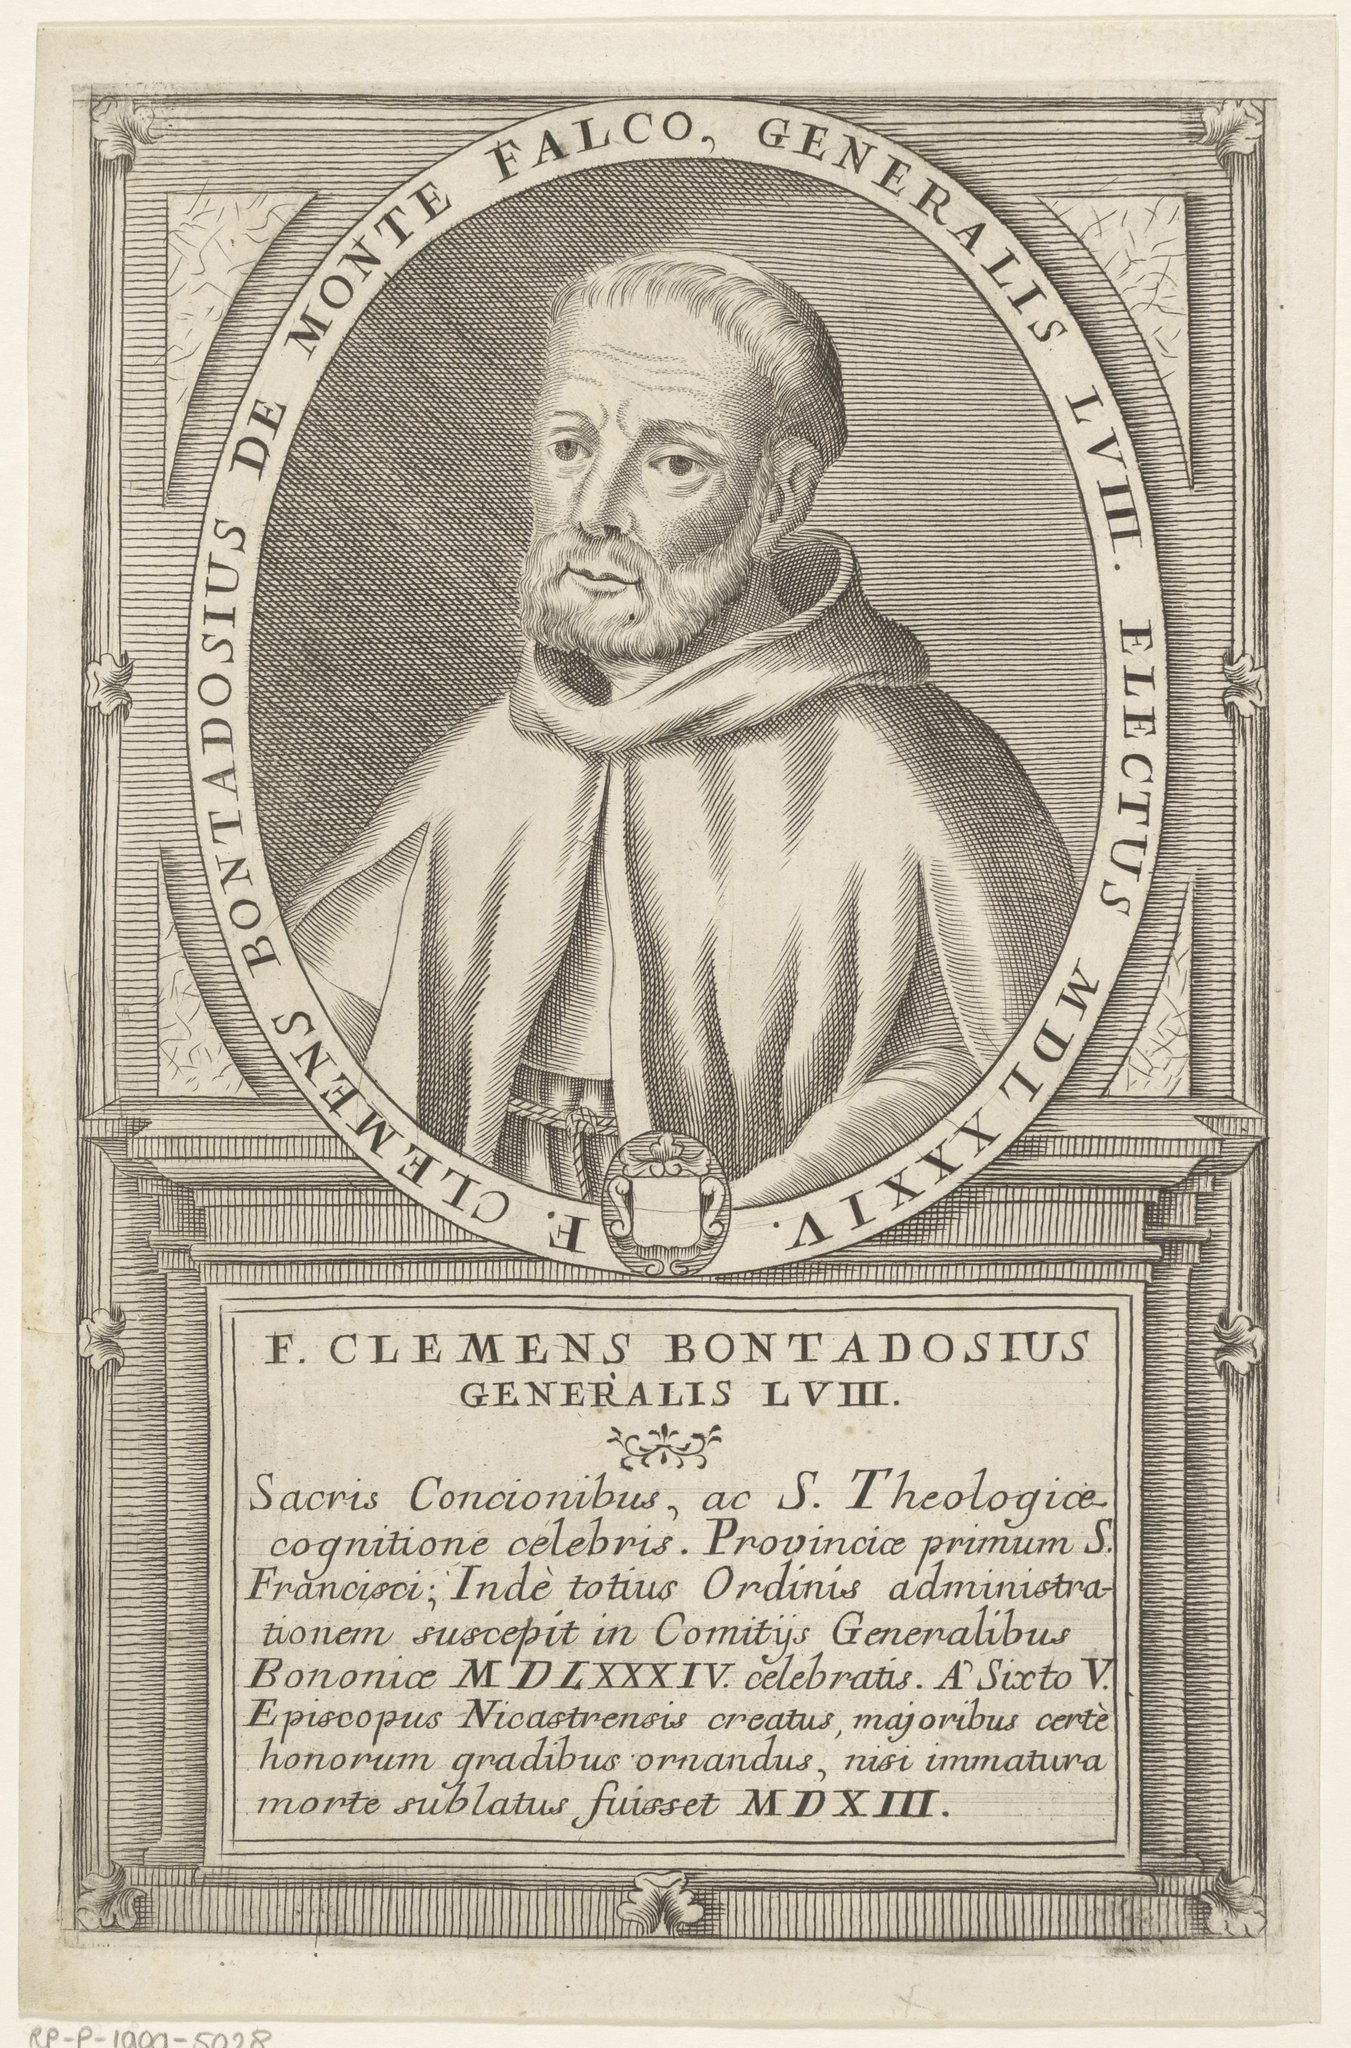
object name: print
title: Portretten van Ministers Generaal van de franciscaner orde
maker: antonio luciani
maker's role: print maker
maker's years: 1700-1738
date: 1710-1738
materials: paper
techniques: engraving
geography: italy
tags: clergyman, historical persons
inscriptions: collector's mark: Lugt 2228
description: Deze prent maakt deel uit van een groep van 60 portretten.